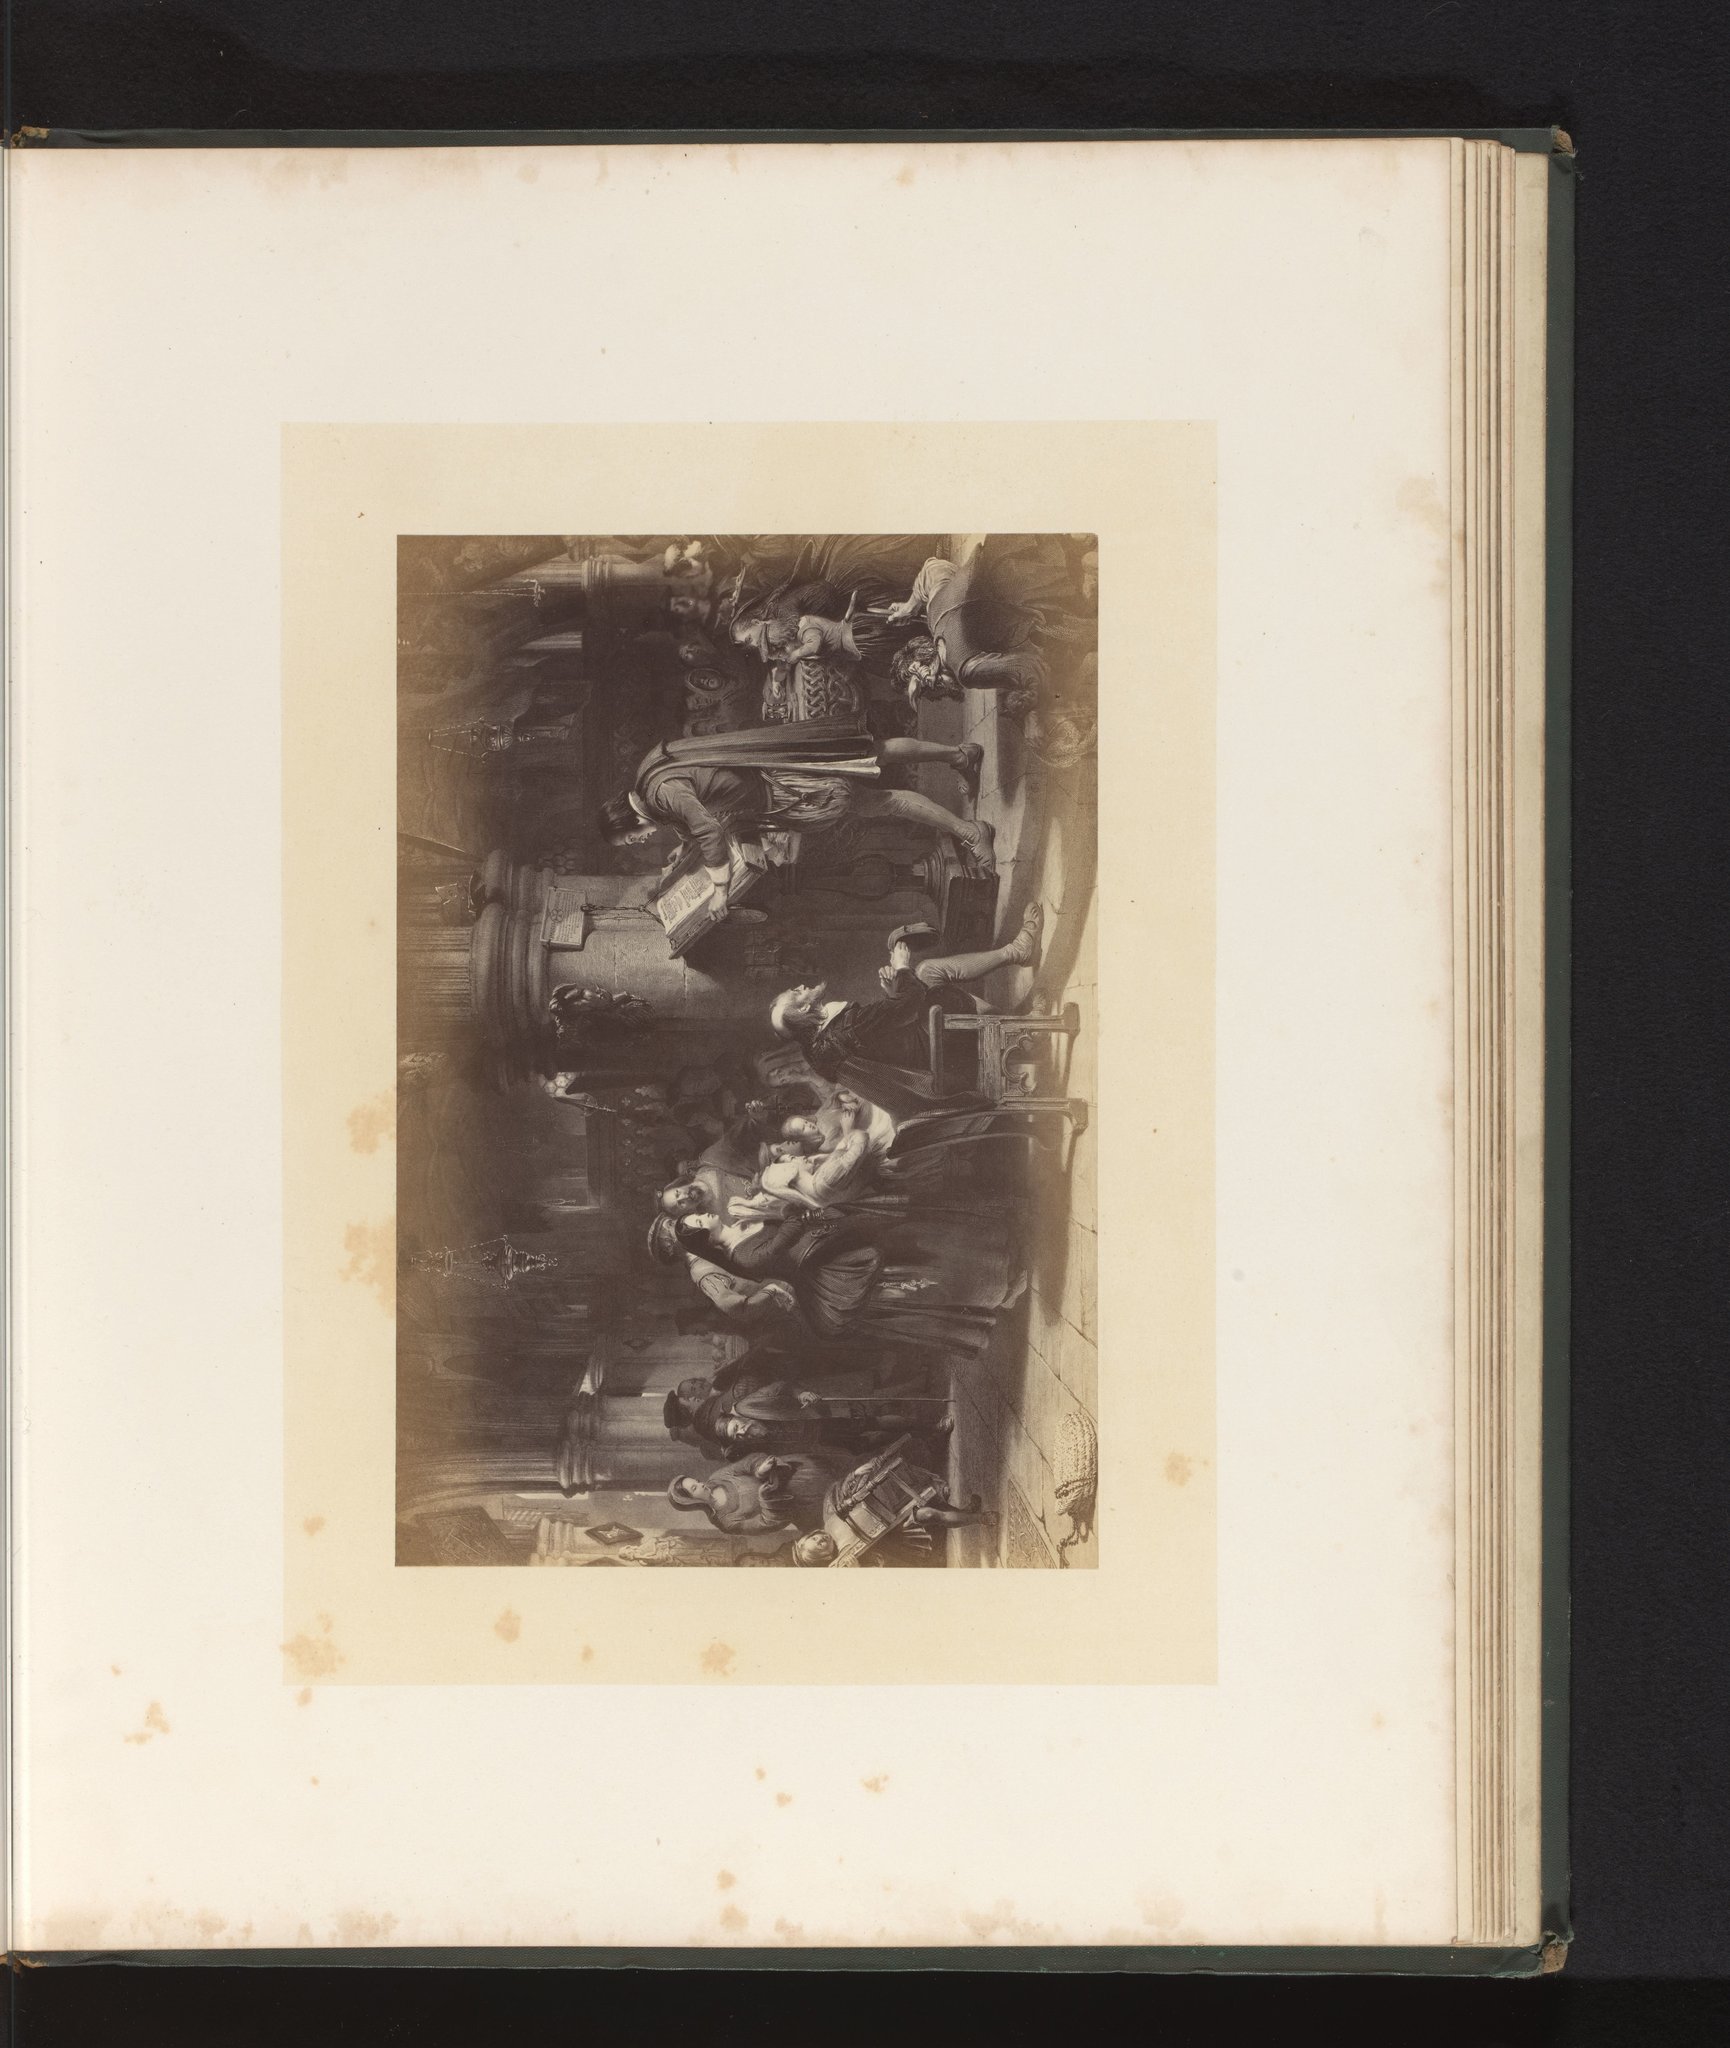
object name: photograph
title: Fotoreproductie van een gravure van First Reading of the Bible in the Crypt of Old St Paul's - Anno 1540, naar het schilderij door Sir George Harvey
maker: thomas annan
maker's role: fotograaf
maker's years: 1829-1887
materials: photographic support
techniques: albumen print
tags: reading the scripture ~ holy mass